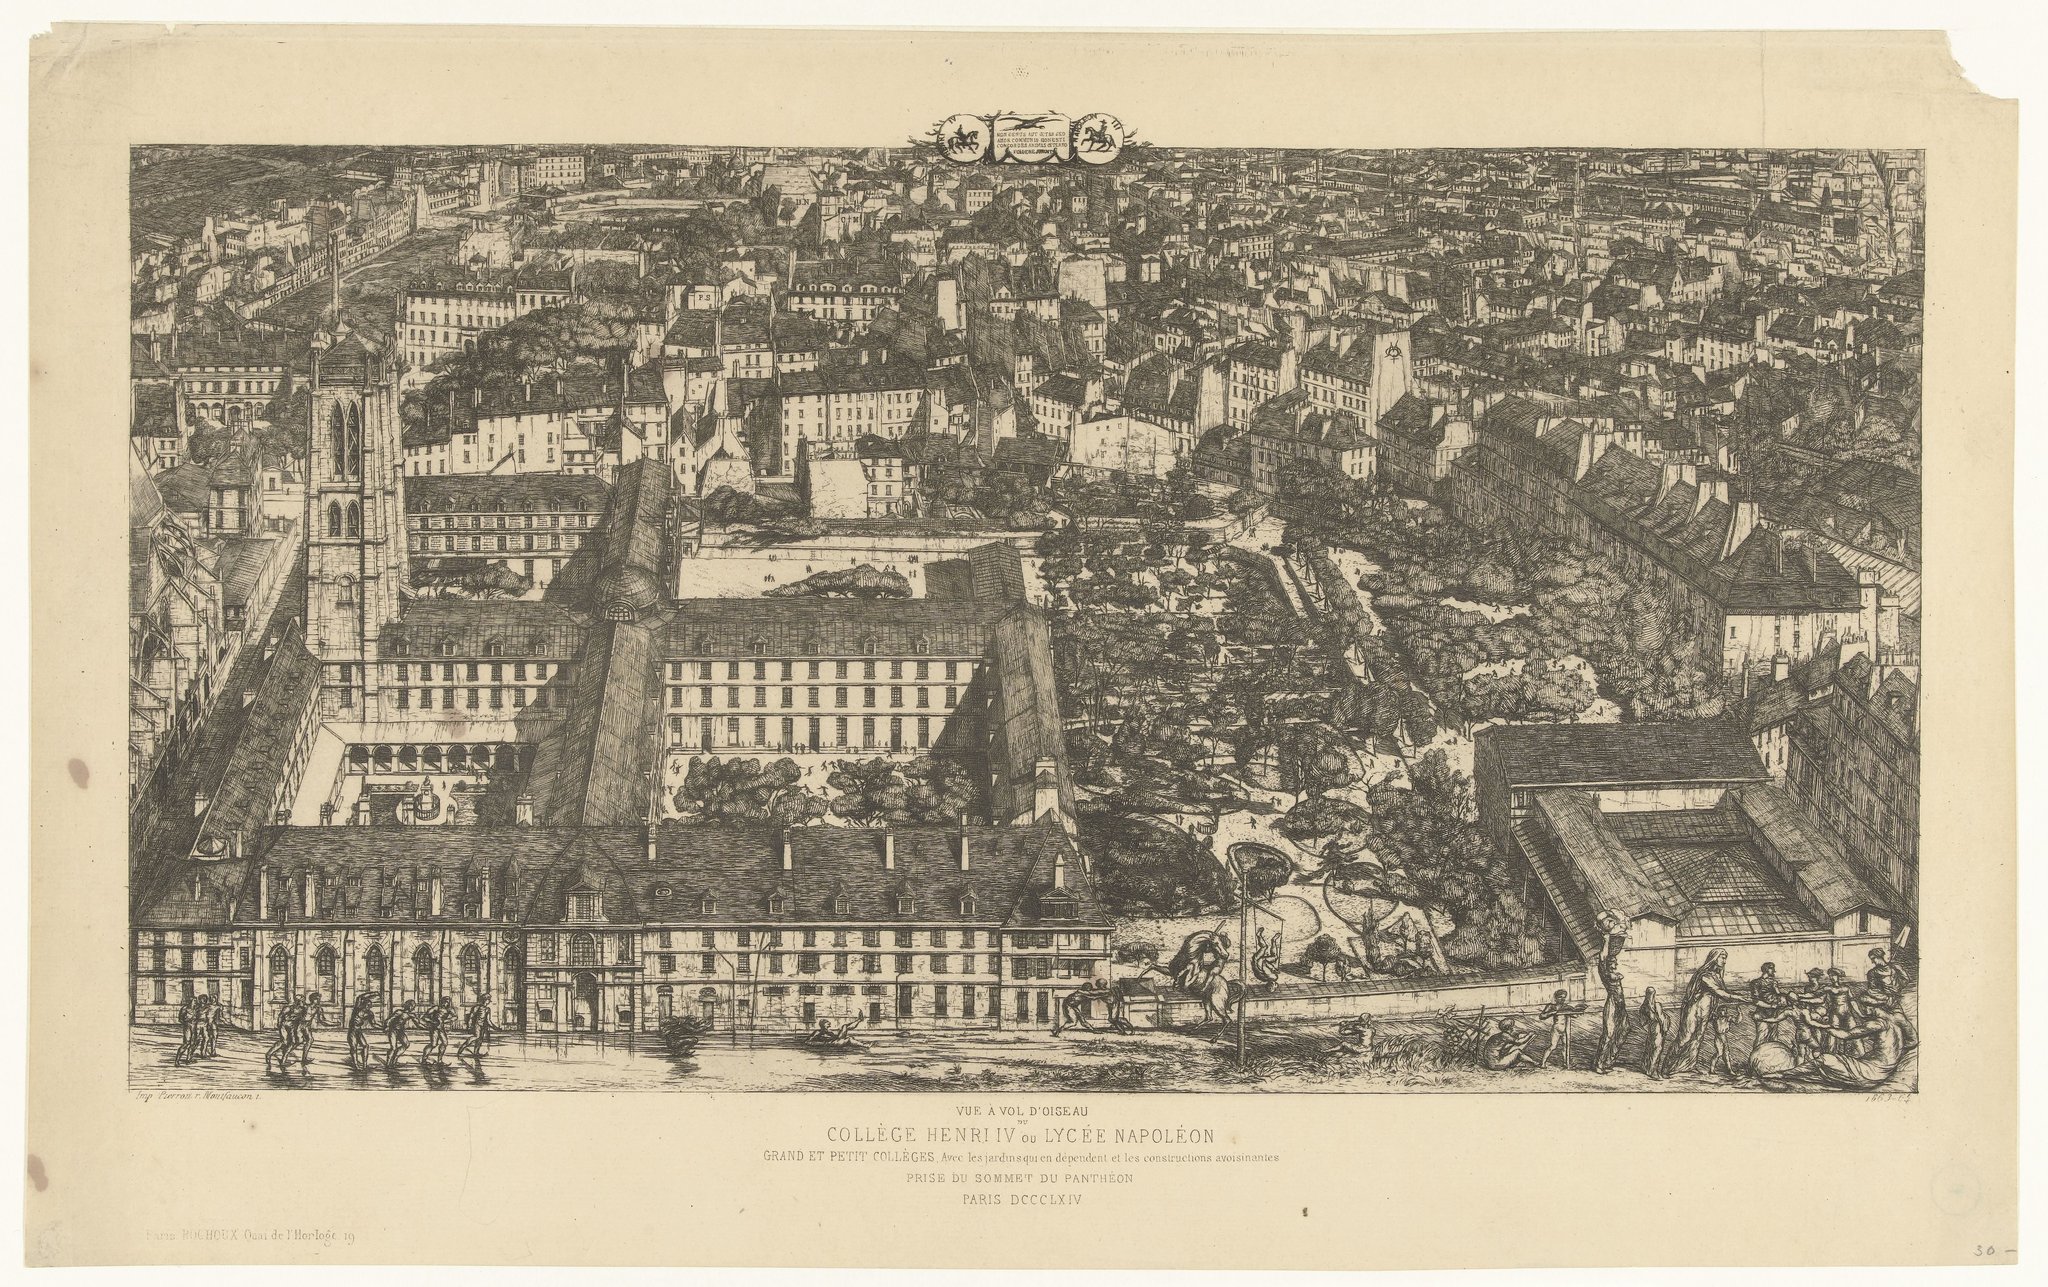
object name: print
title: Lyceum Henri IV in Parijs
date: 1863-1864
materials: paper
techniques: etching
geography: paris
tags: university building, college, bird's eye view ~ representation of building, paris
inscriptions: collector's mark:, collector's mark:, collector's mark: Lugt 2228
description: Het lyceum Henri IV in Parijs weergegeven in vogelvluchtperspectief, het gebouw is tot in kleine details uitgewerkt. Op de voorgrond zijn schaatsende figuren weergegeven en figuren die zich bezig houden met andere lichamelijke oefeningen. Opvallend is het verschil in verhoudingen ten opzichte van de gebouwen en de kleine figuurtjes in het landschap. Ook de figuren in de rij bij Caritas, rechts op de voorgrond, zijn groot weergegeven. In de zevende staat wijzigde de kunstenaar de voorstelling ingrijpend, hij vulde het blad tot boven aan toe met bebouwing en verving daarmee het vrijwel lege vlak met lucht en de zee aan de horizon.